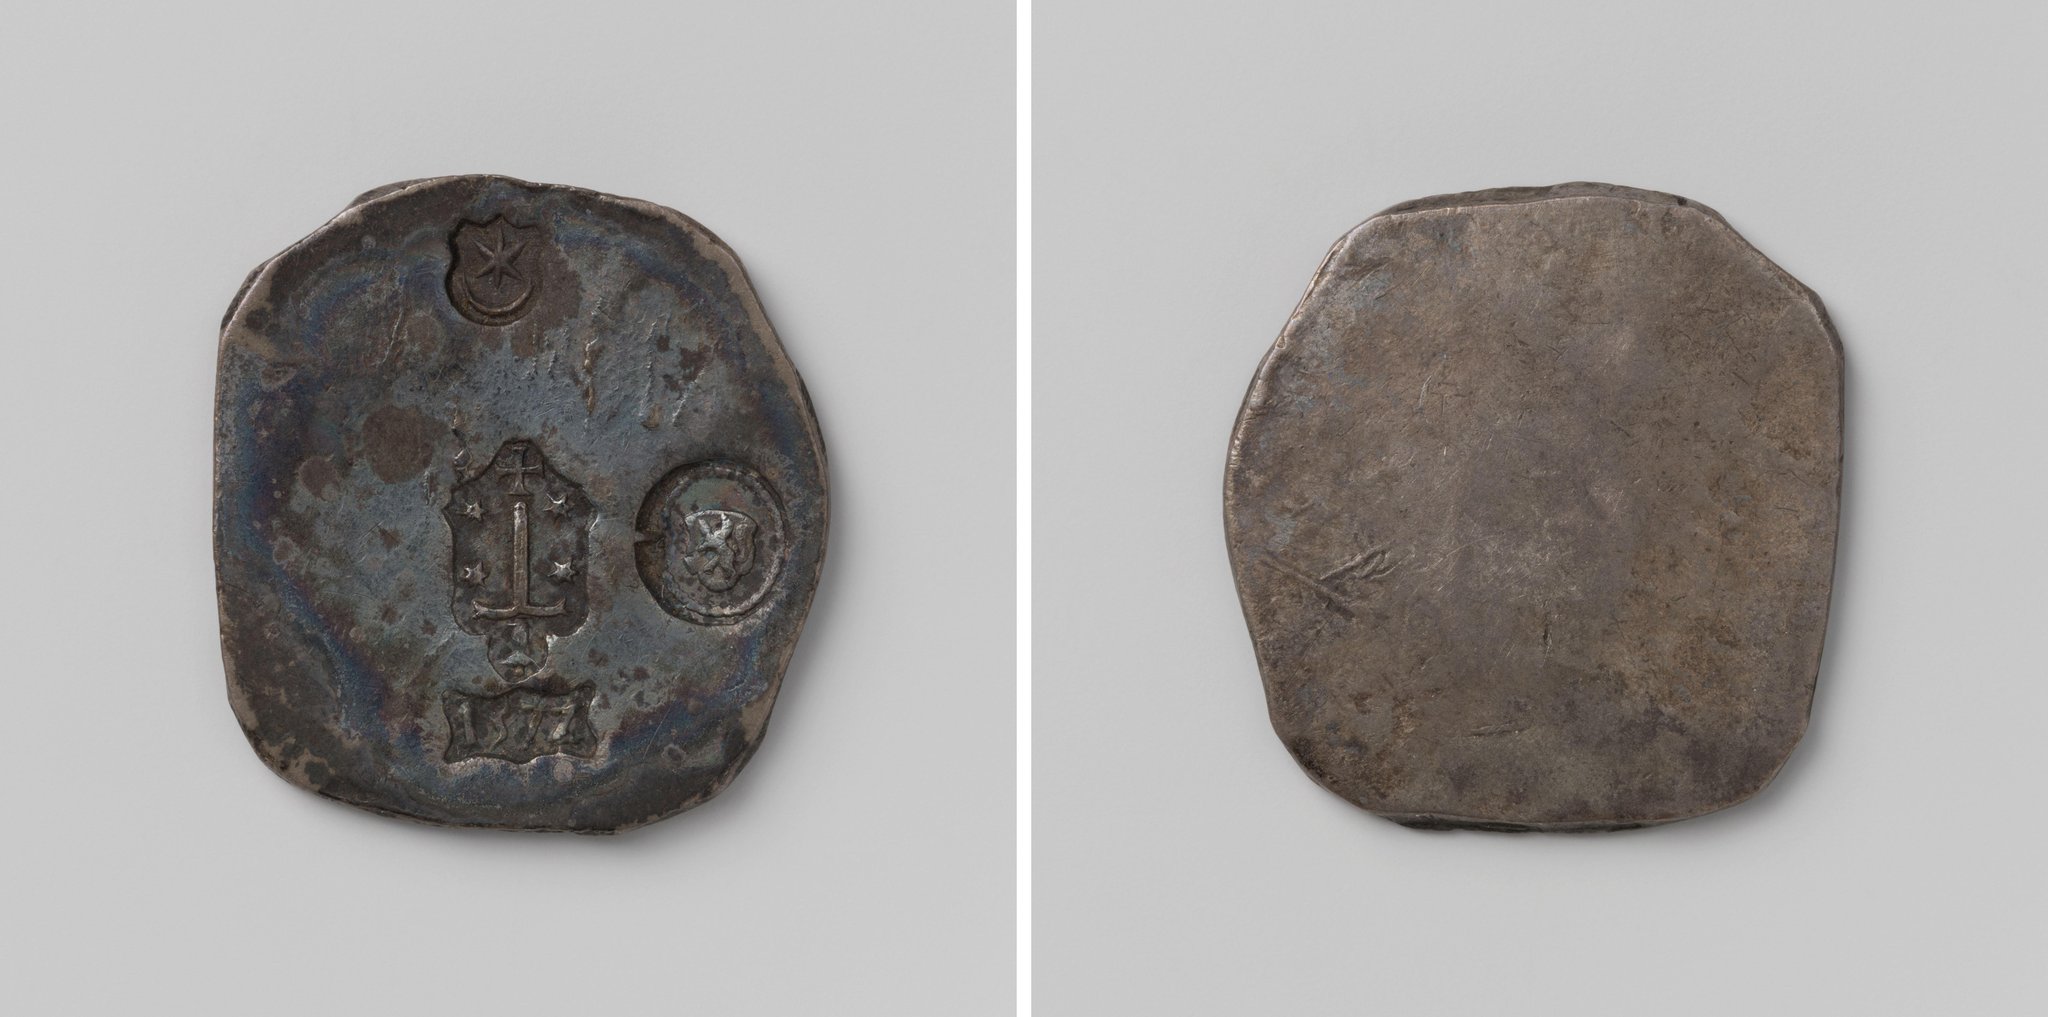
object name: siege coin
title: Halve daalder, noodmunt uit Haarlem, geslagen tijdens het beleg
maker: Anonymous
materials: silver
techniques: striking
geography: haarlem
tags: haarlem